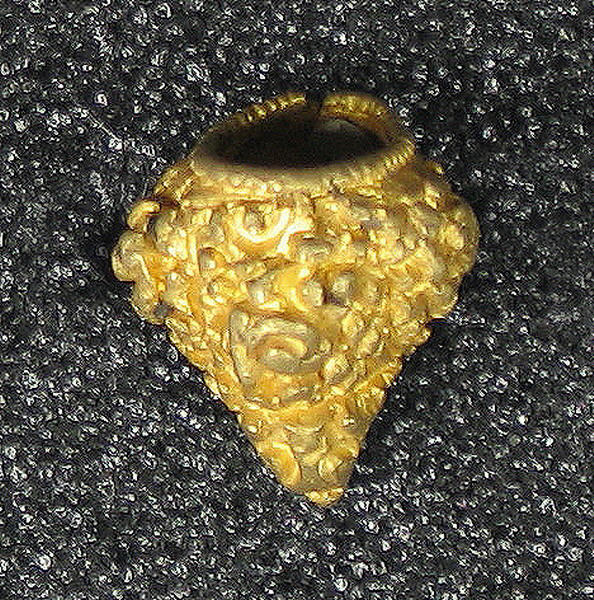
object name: earring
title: Earring cast with Mount Meru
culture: indonesian, central java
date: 701-1200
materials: gold